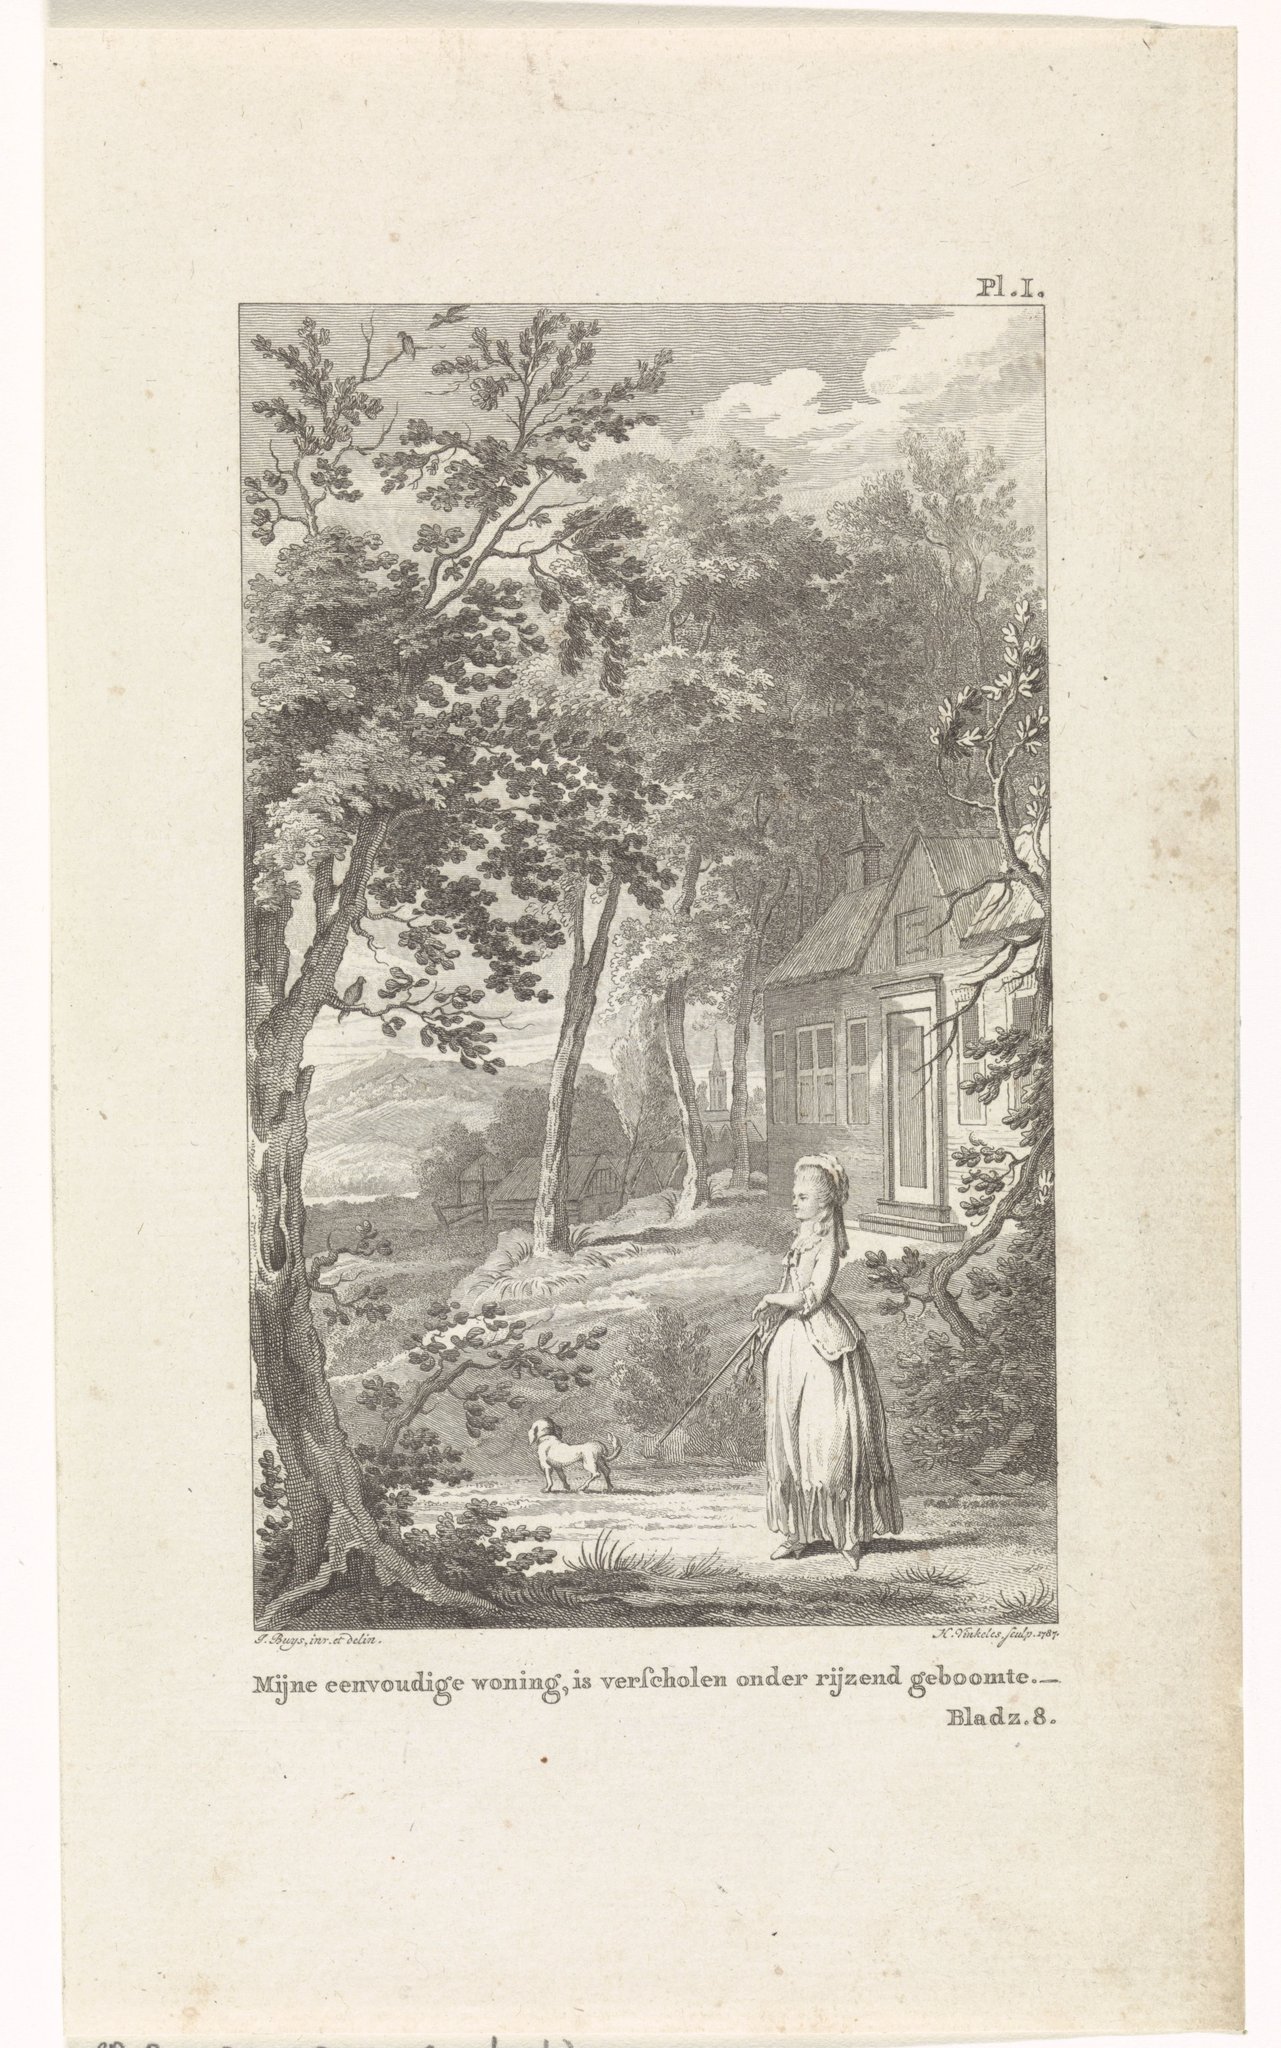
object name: print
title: Vrouw met een hond bij een huis in een landschap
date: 1787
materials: paper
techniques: engraving, etching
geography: amsterdam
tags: farm or solitary house in landscape, dog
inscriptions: collector's mark: Lugt 2760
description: Prent gebruikt als boekillustratie in: Post, Anna Maria. Het land, in brieven. Amsterdam: Johannes Allart, 1788.